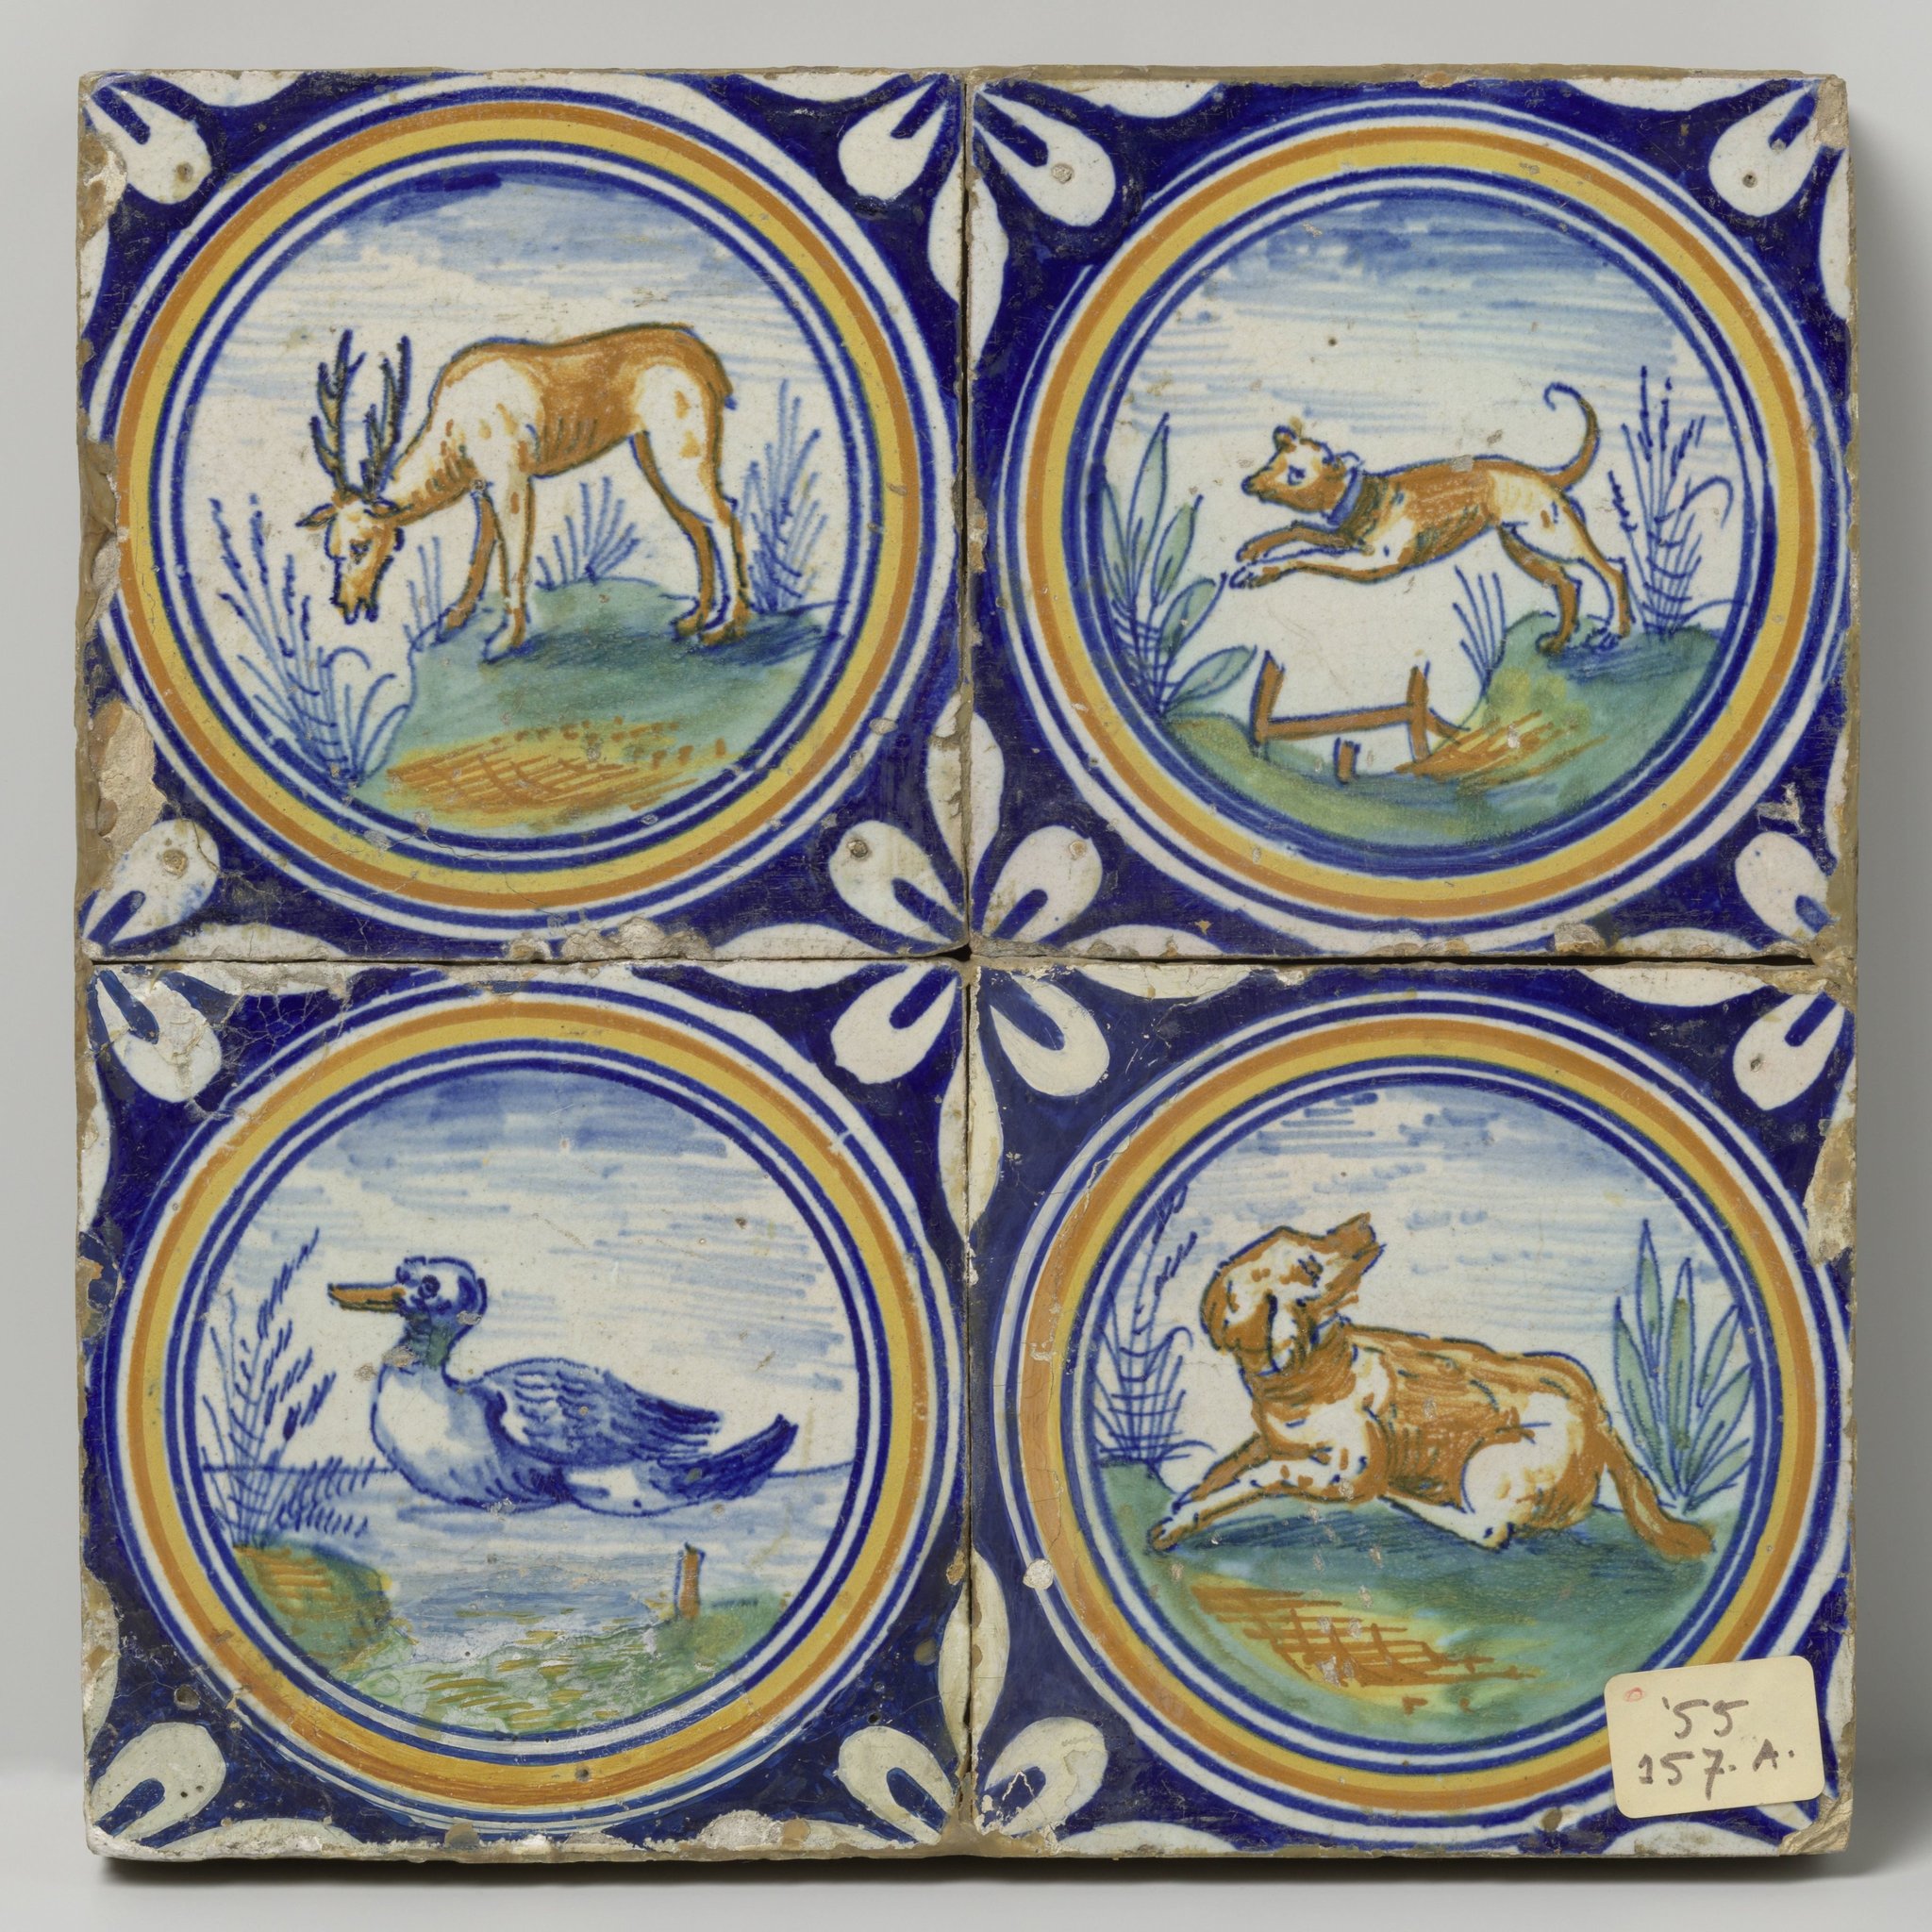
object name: tile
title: Veld van vier tegels met dieren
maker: Anonymous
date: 1580-1625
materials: earthenware, glaze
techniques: maiolica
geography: netherlands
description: Veld van vier tegels elk met een veelkleurig (blauw, oranje, groen, geel en paars) dier op een grond binnen een cirkel omlijsting. In de hoeken, vultechniek ornament.